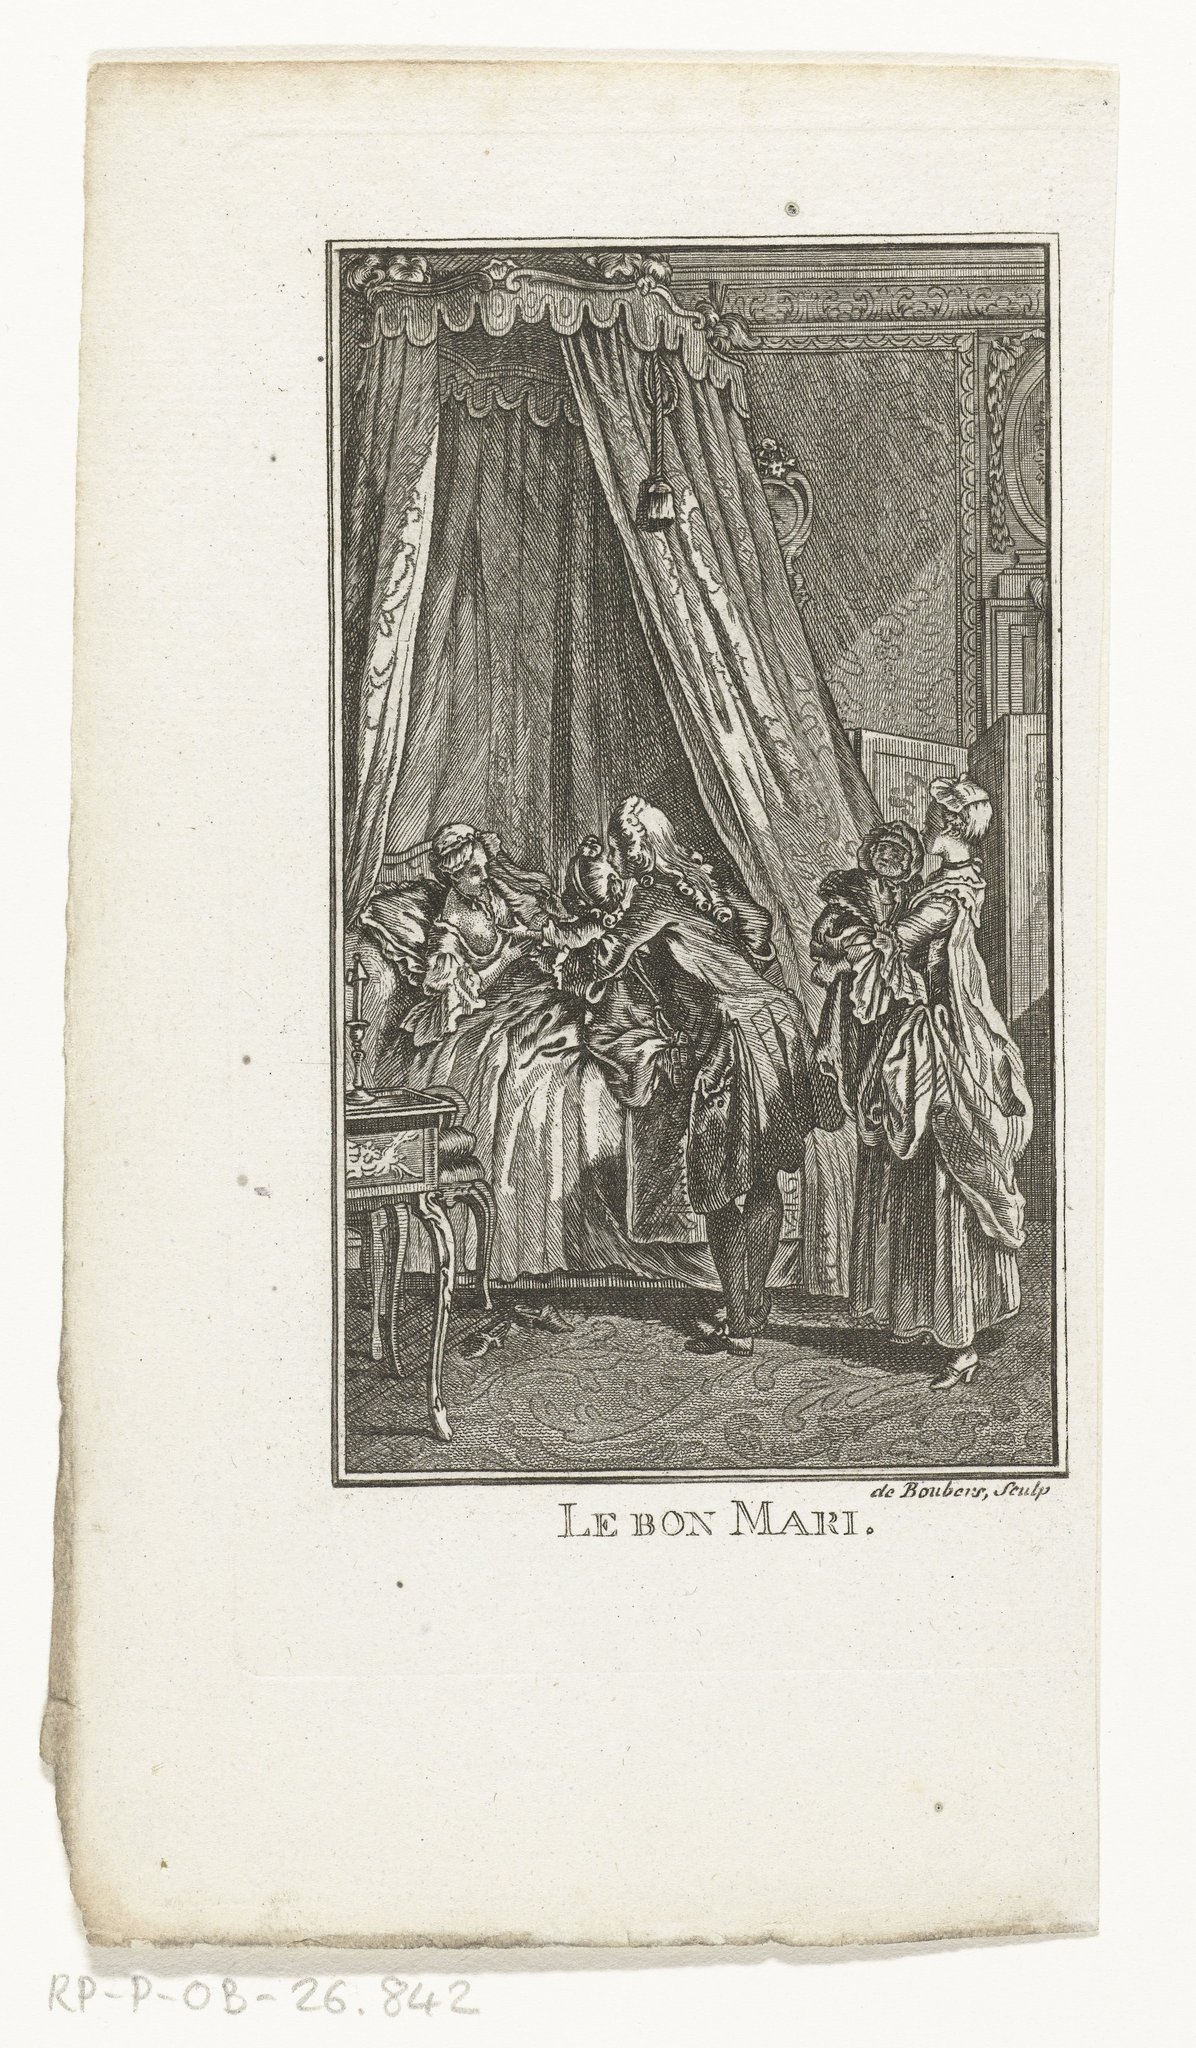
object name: book illustration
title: De goede echtgenoot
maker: n. de boubers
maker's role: print maker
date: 1765-1780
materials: paper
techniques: engraving, etching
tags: partner deceived, ideal husband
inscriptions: collector's mark: Lugt 2228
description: Illustratie voor het verhaal 'Le Bon Mari' uit J.F. Marmontel's verhalenbundel 'Contes moreaux'. Nadat ze weduwe is geworden trouwt Hortensia met haar neef Lusane. Hij zorgt goed voor haar en de twee kinderen uit haar eerste huwelijk. Hortensia ligt in bed en Lusane brengt haar haar kinderen.